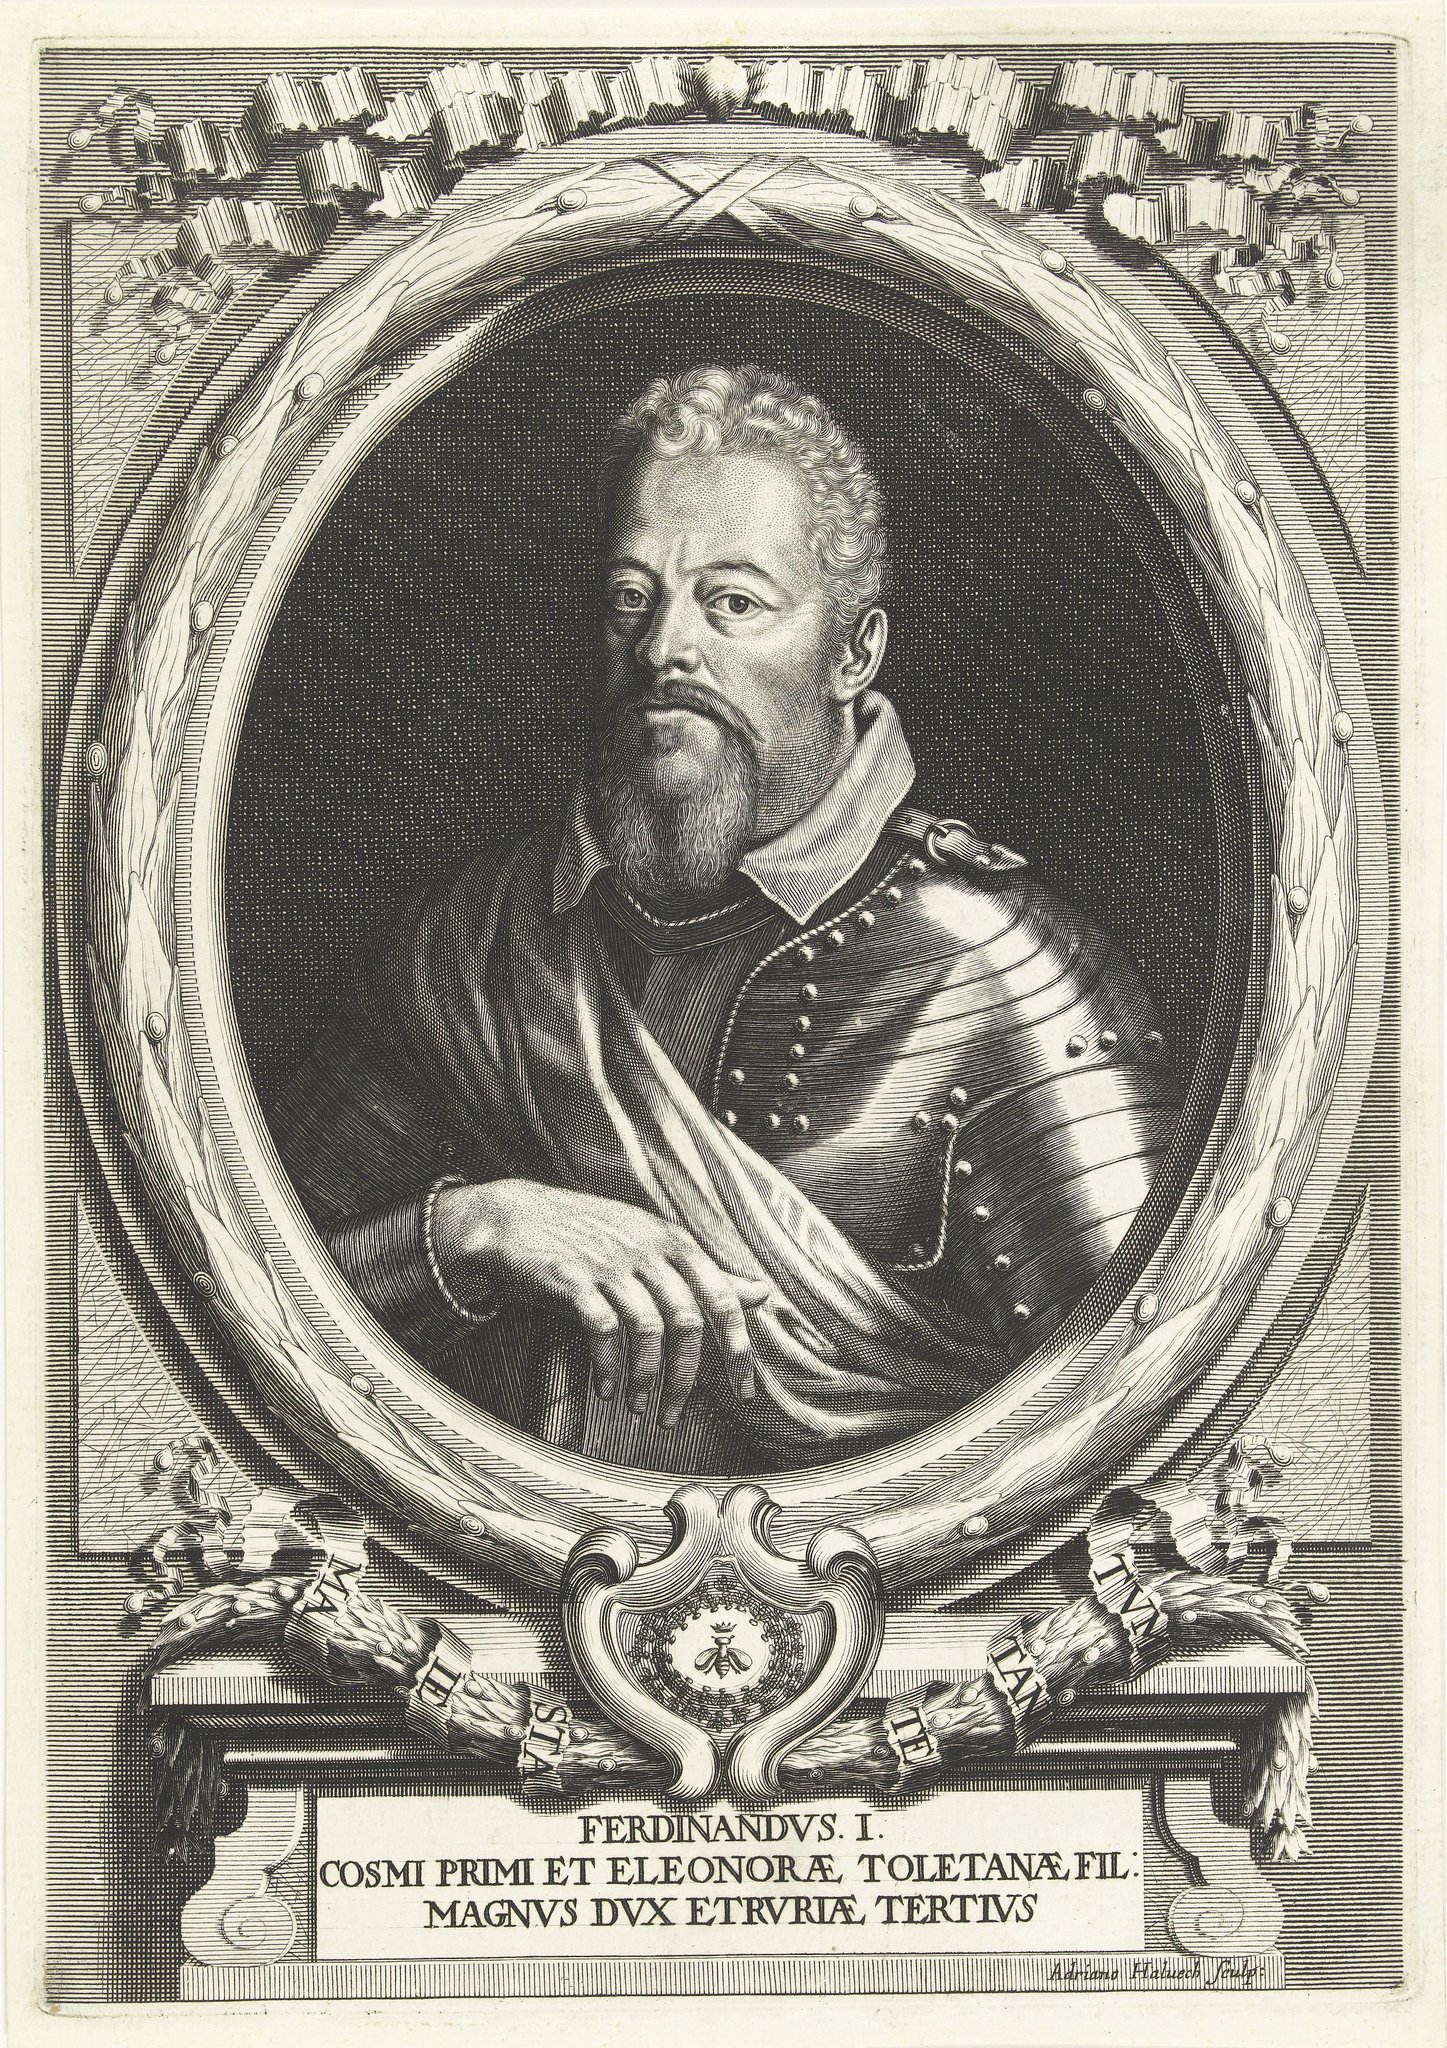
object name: print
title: Portretten van de familie De' Medici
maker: adriaen haelwegh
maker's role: print maker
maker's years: 1637-1702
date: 1647-1696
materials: paper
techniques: engraving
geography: northern netherlands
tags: ferdinando i de' medici, military clothing and other equipment (uniforms, cap, armour, helmet, etc.)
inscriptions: collector's mark: Lugt 2228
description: Portret ten halven lijve naar links van Ferdinando I de Medici, groothertog van Toscane, zoon van Cosimo I en Eleonora van Toledo, met een harnas aan, in een ovaal omringd met een lauwerkrans. Onderaan in een cartouche een bij met een kroontje, omkranst met ander bijen. Daaronder op een tablet onder een plint zijn naam en twee regels in Latijn.